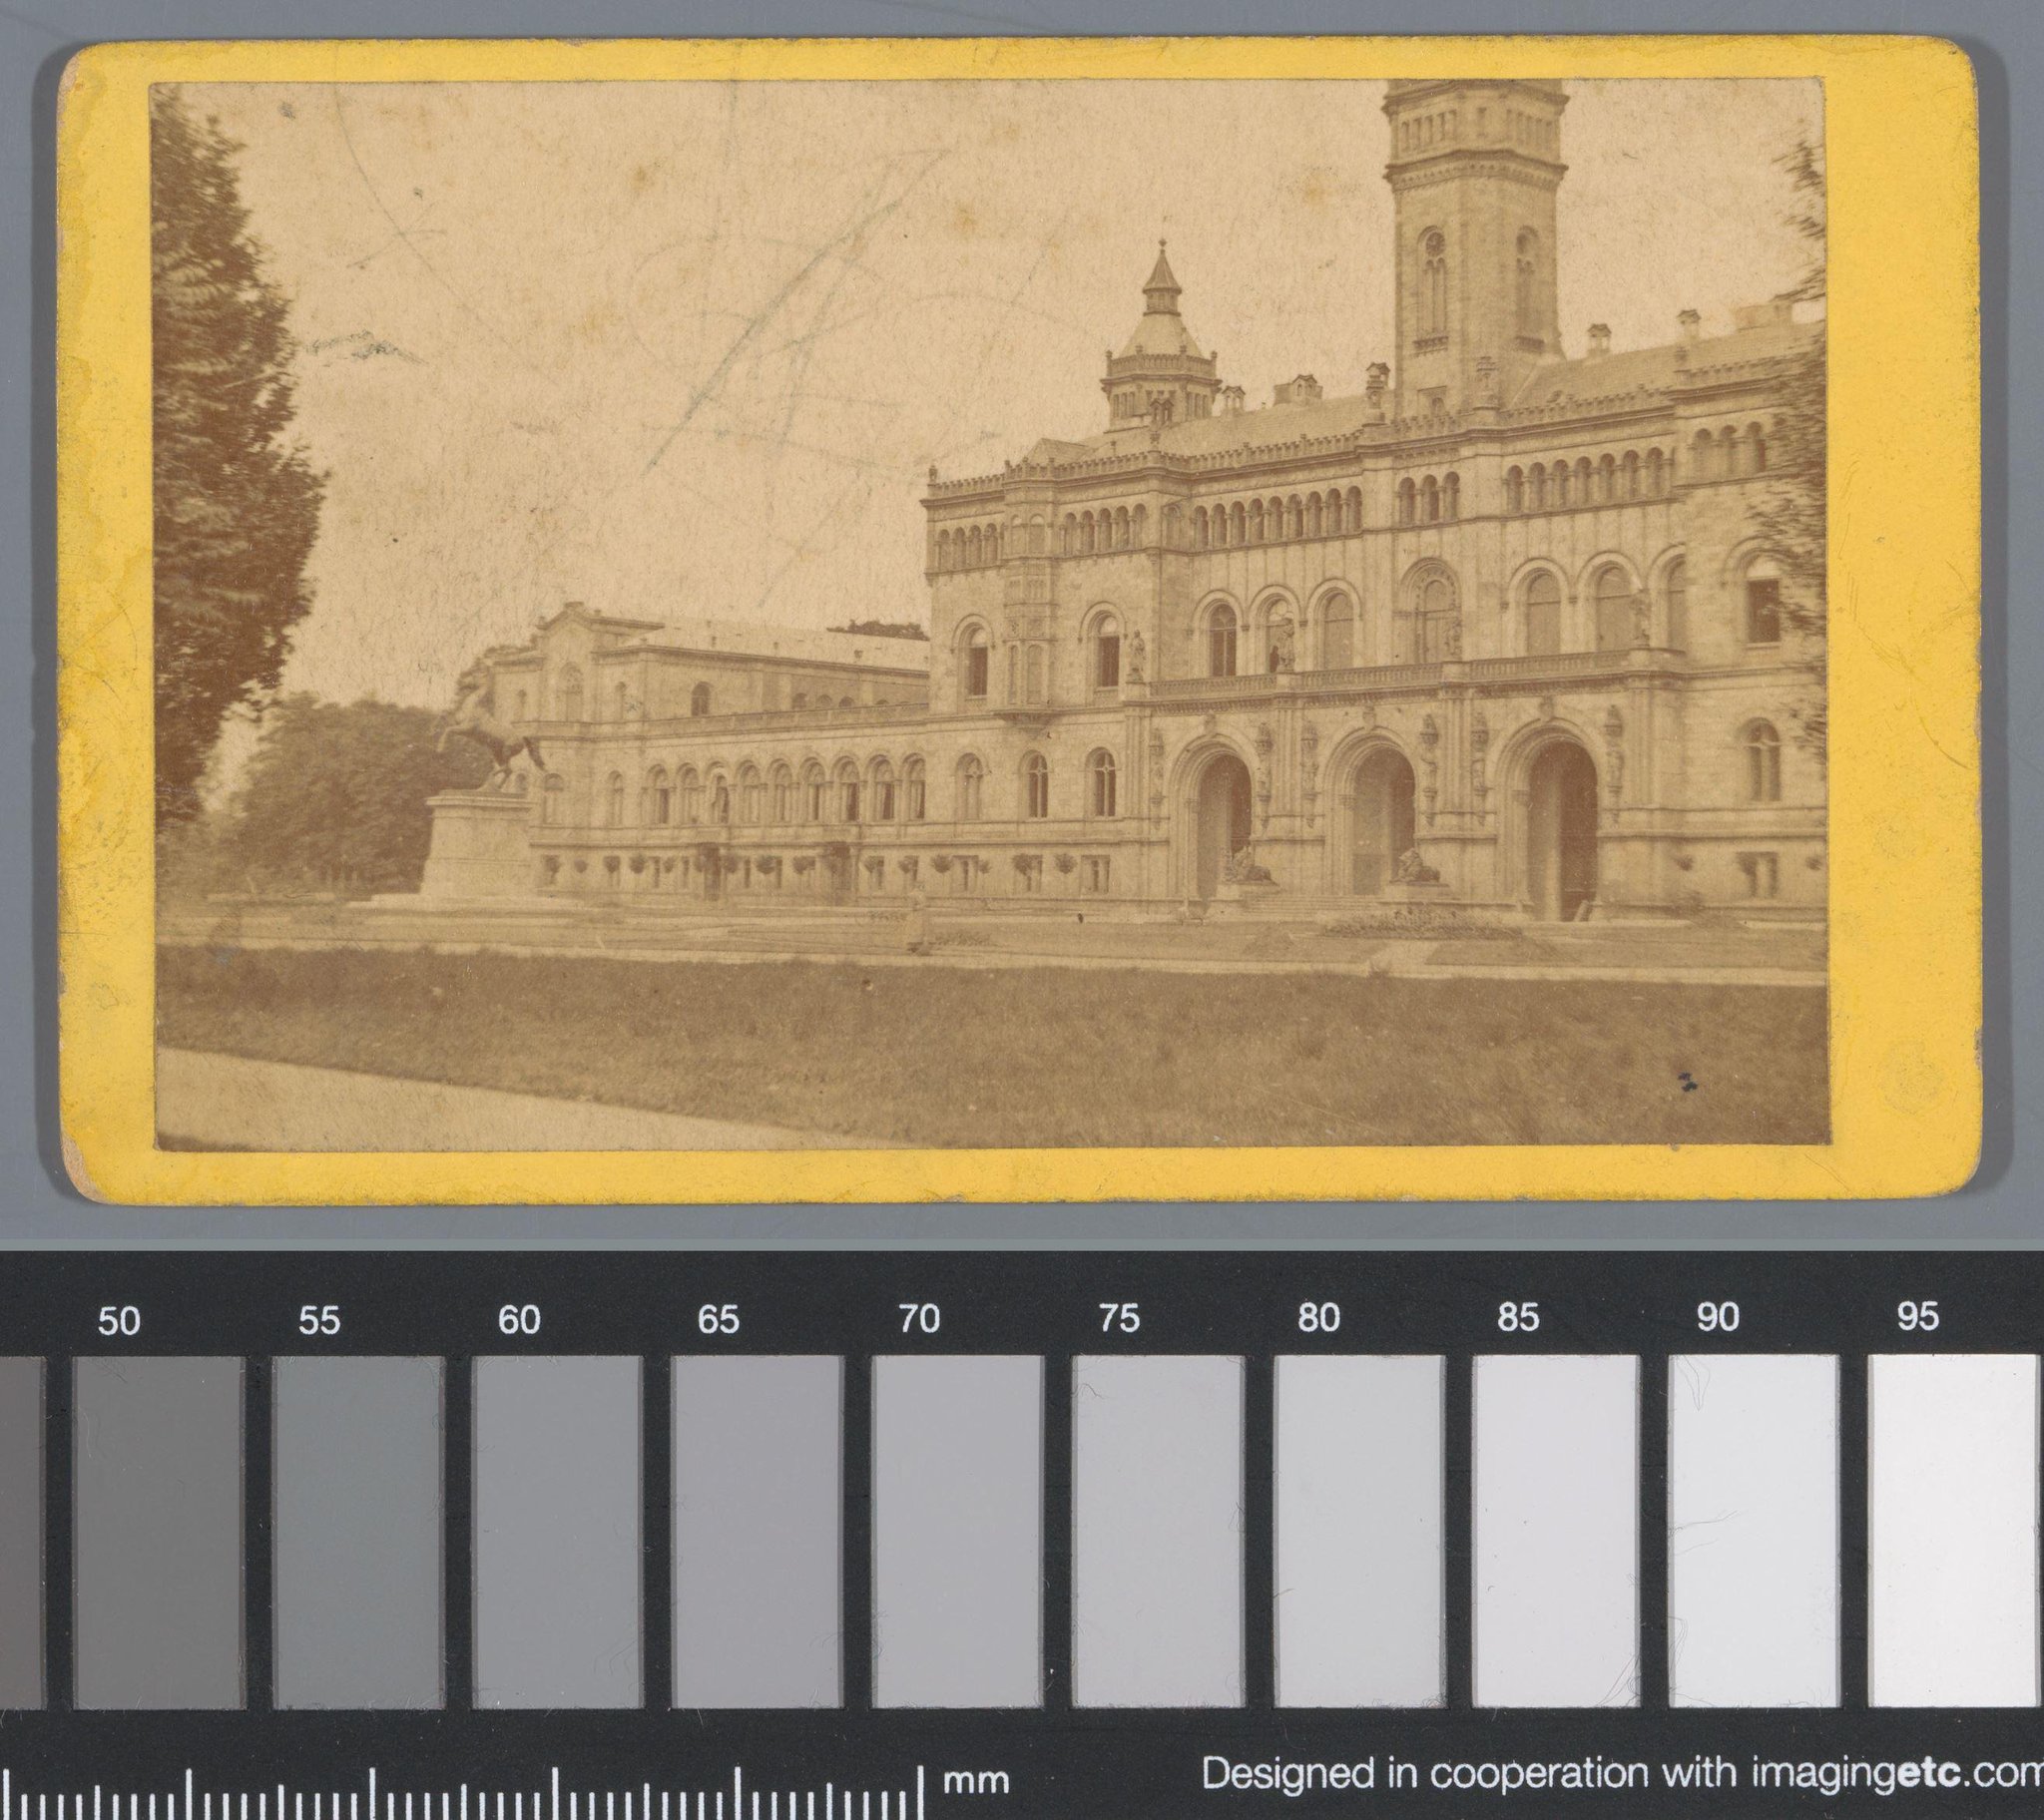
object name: carte de visite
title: Gezicht op een paleis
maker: Anonymous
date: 1854-1885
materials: cardboard, paper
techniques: albumen print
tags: palace